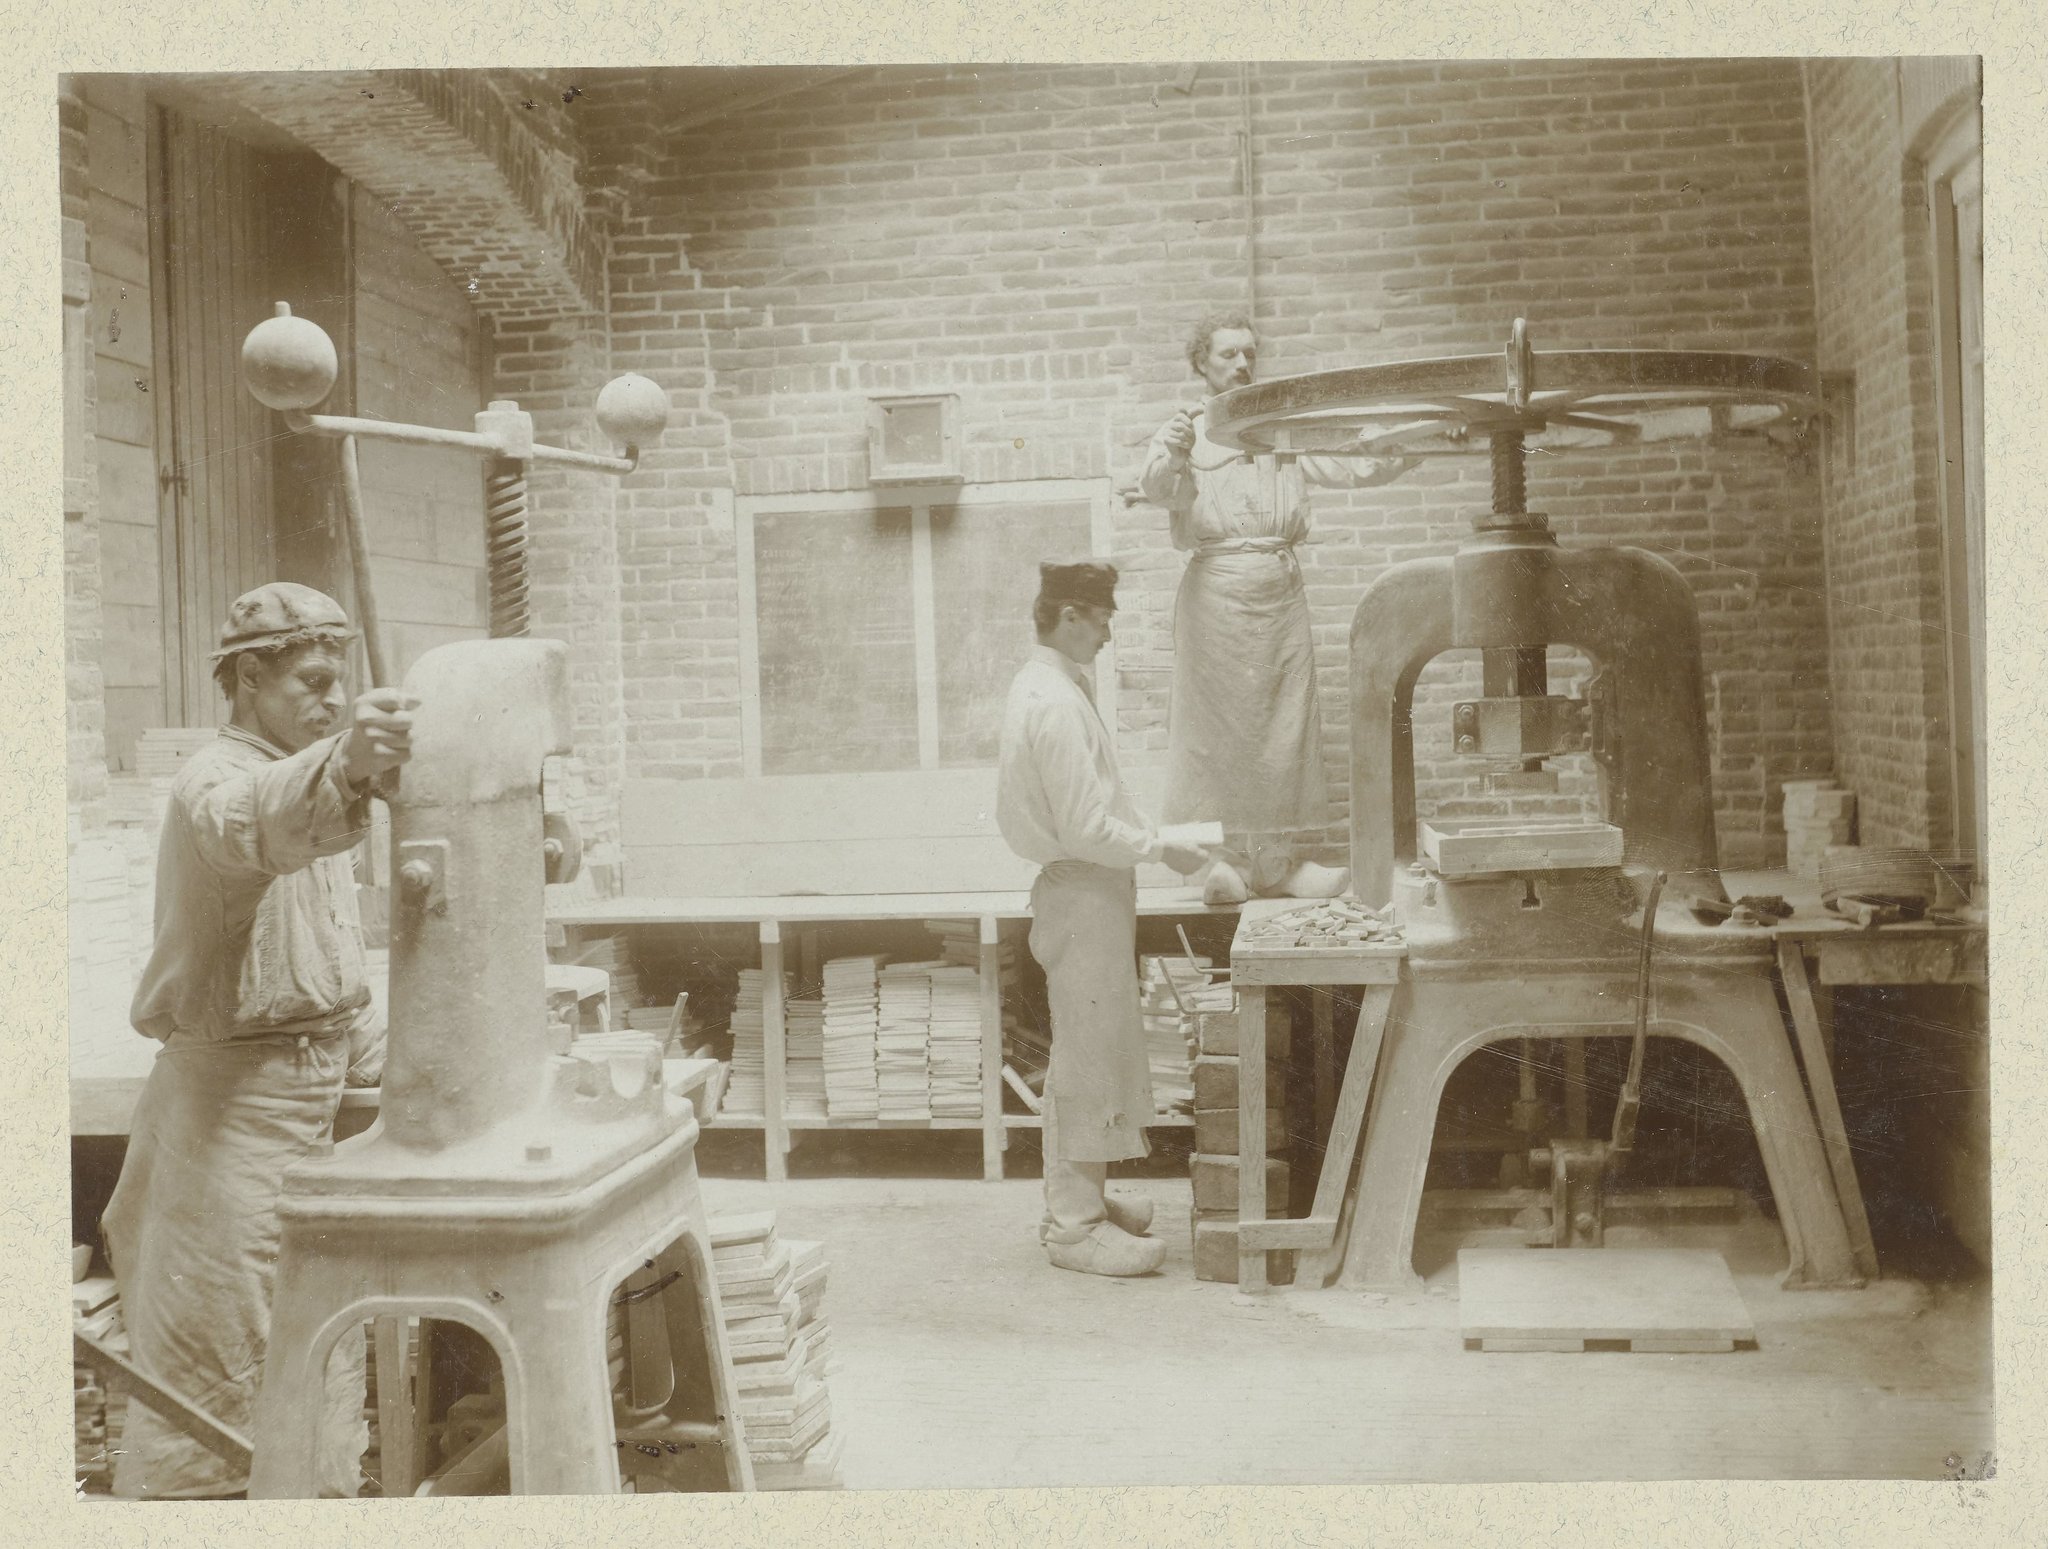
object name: photograph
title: Tegelpers van de porseleinfabriek Rozenburg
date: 1890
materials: cardboard, paper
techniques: collodion silver print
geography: the hague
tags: workshop-interior, the hague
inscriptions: stamp: ‘Ritscher & Landsman photografen Den Haag’